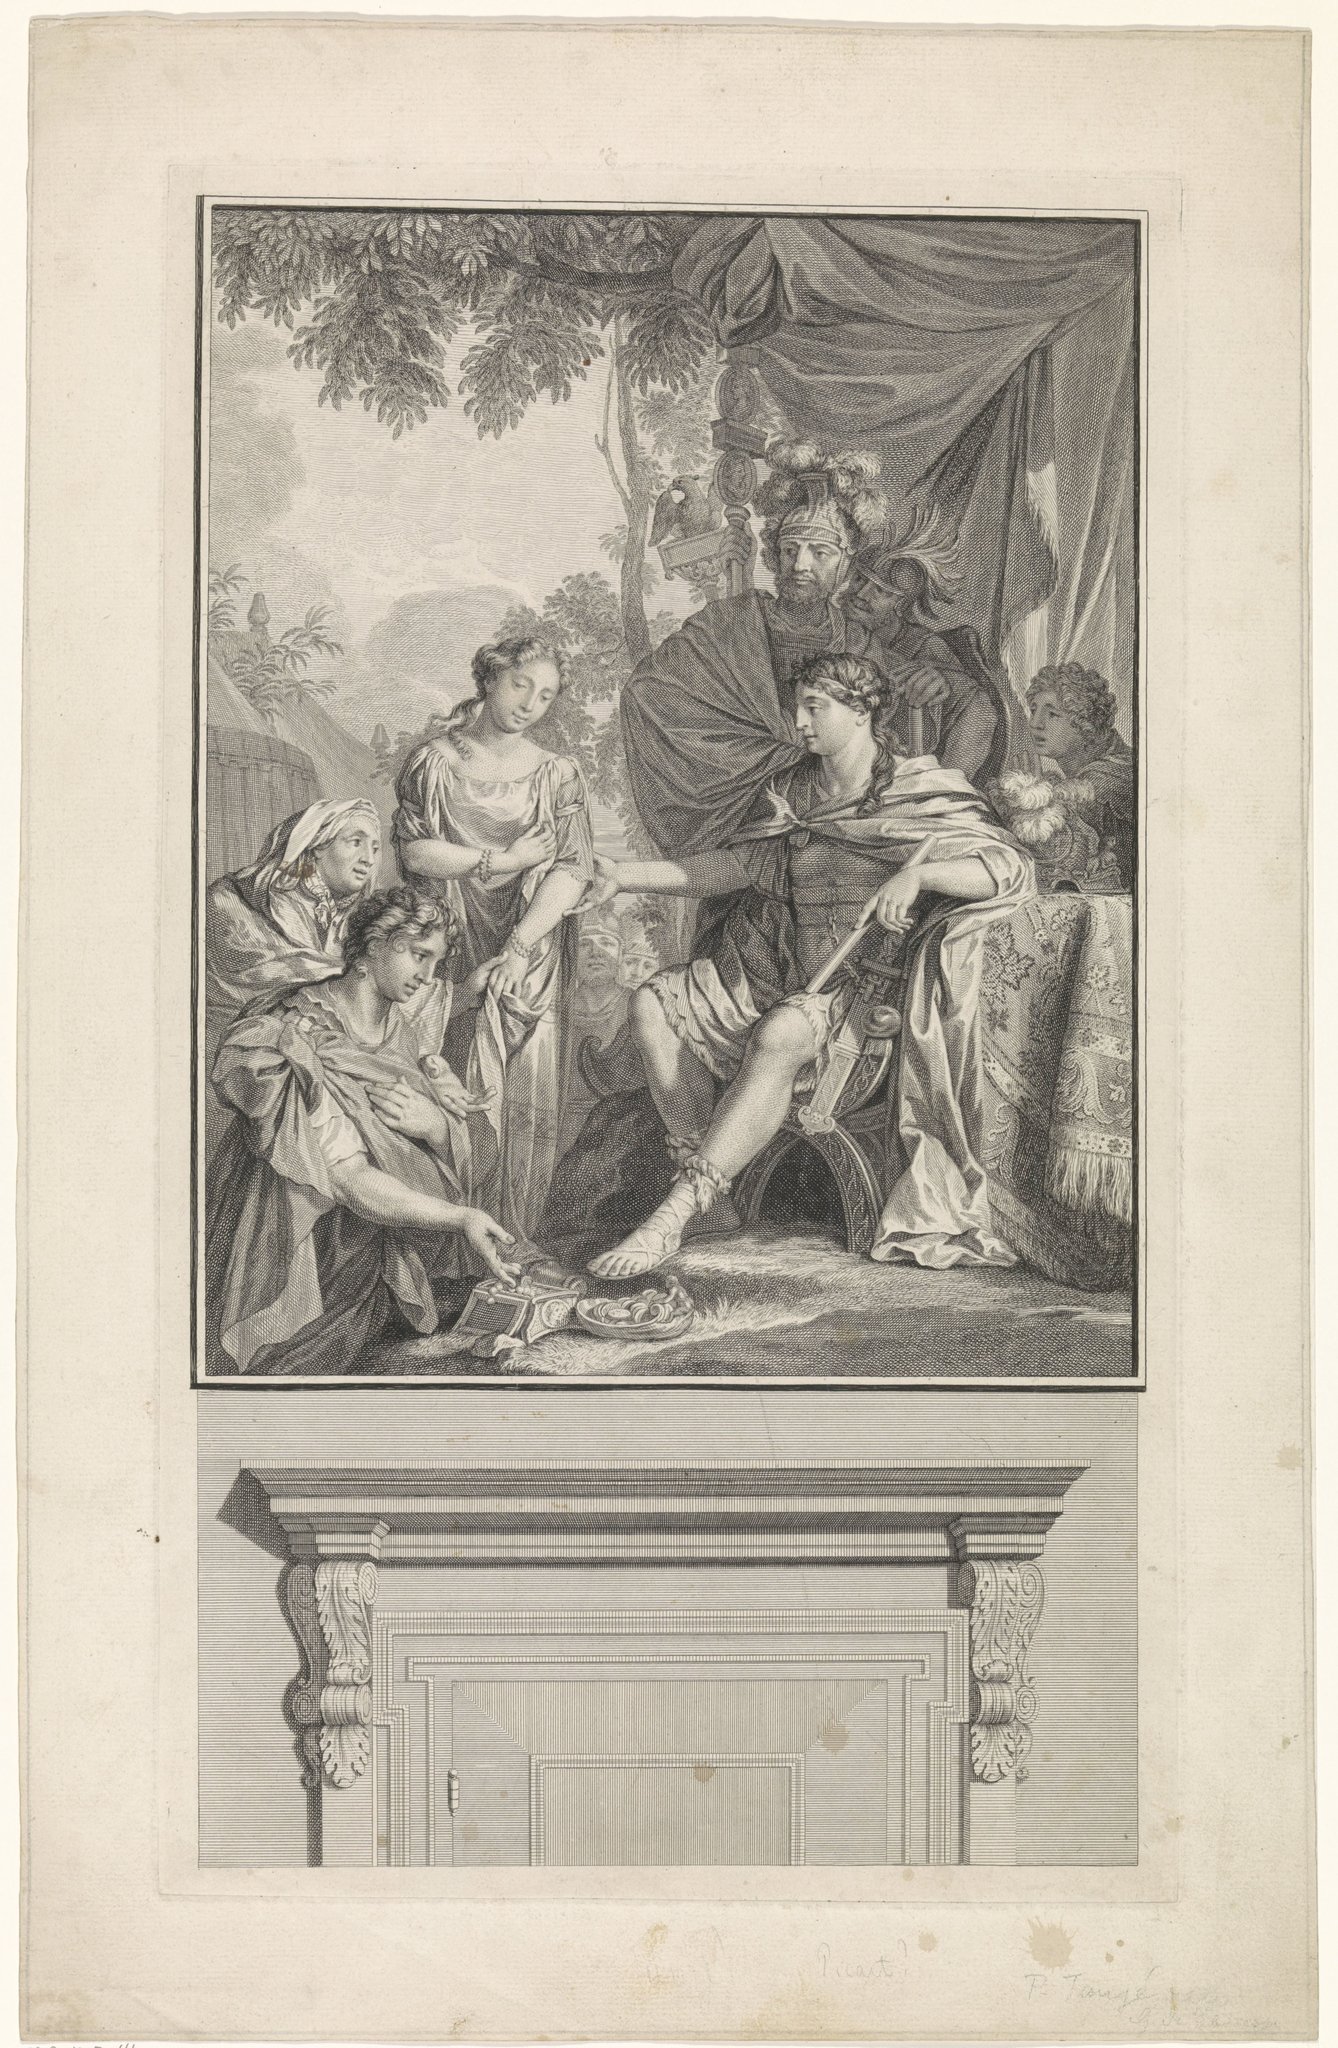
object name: print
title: Edelmoedigheid van Scipio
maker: pieter tanjé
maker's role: draughtsman, print maker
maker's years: 1706-1761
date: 1737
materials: paper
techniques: engraving, etching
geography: amsterdam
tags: the continence of scipio: he restores a captive woman to her bridegroom allucius, who kneels before him; the ransom offered by the bride's parents is given to allucius as a wedding-gift, door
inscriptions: collector's mark: Lugt 2228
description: Scipio geeft de schone maagd, die hem als beloning voor het veroveren van Nieuw Carthago was aangeboden, terug aan haar aanstaande bruidegom en haar moeder. Het losgeld, aangeboden door de ouders van de bruid, geeft Scipio terug als huwelijksgeschenk. Voorstelling boven een van de deuren van de Raadkamer van het Hof van Justitie van Holland, Zeeland en West-Friesland in het Binnenhof te Den Haag.